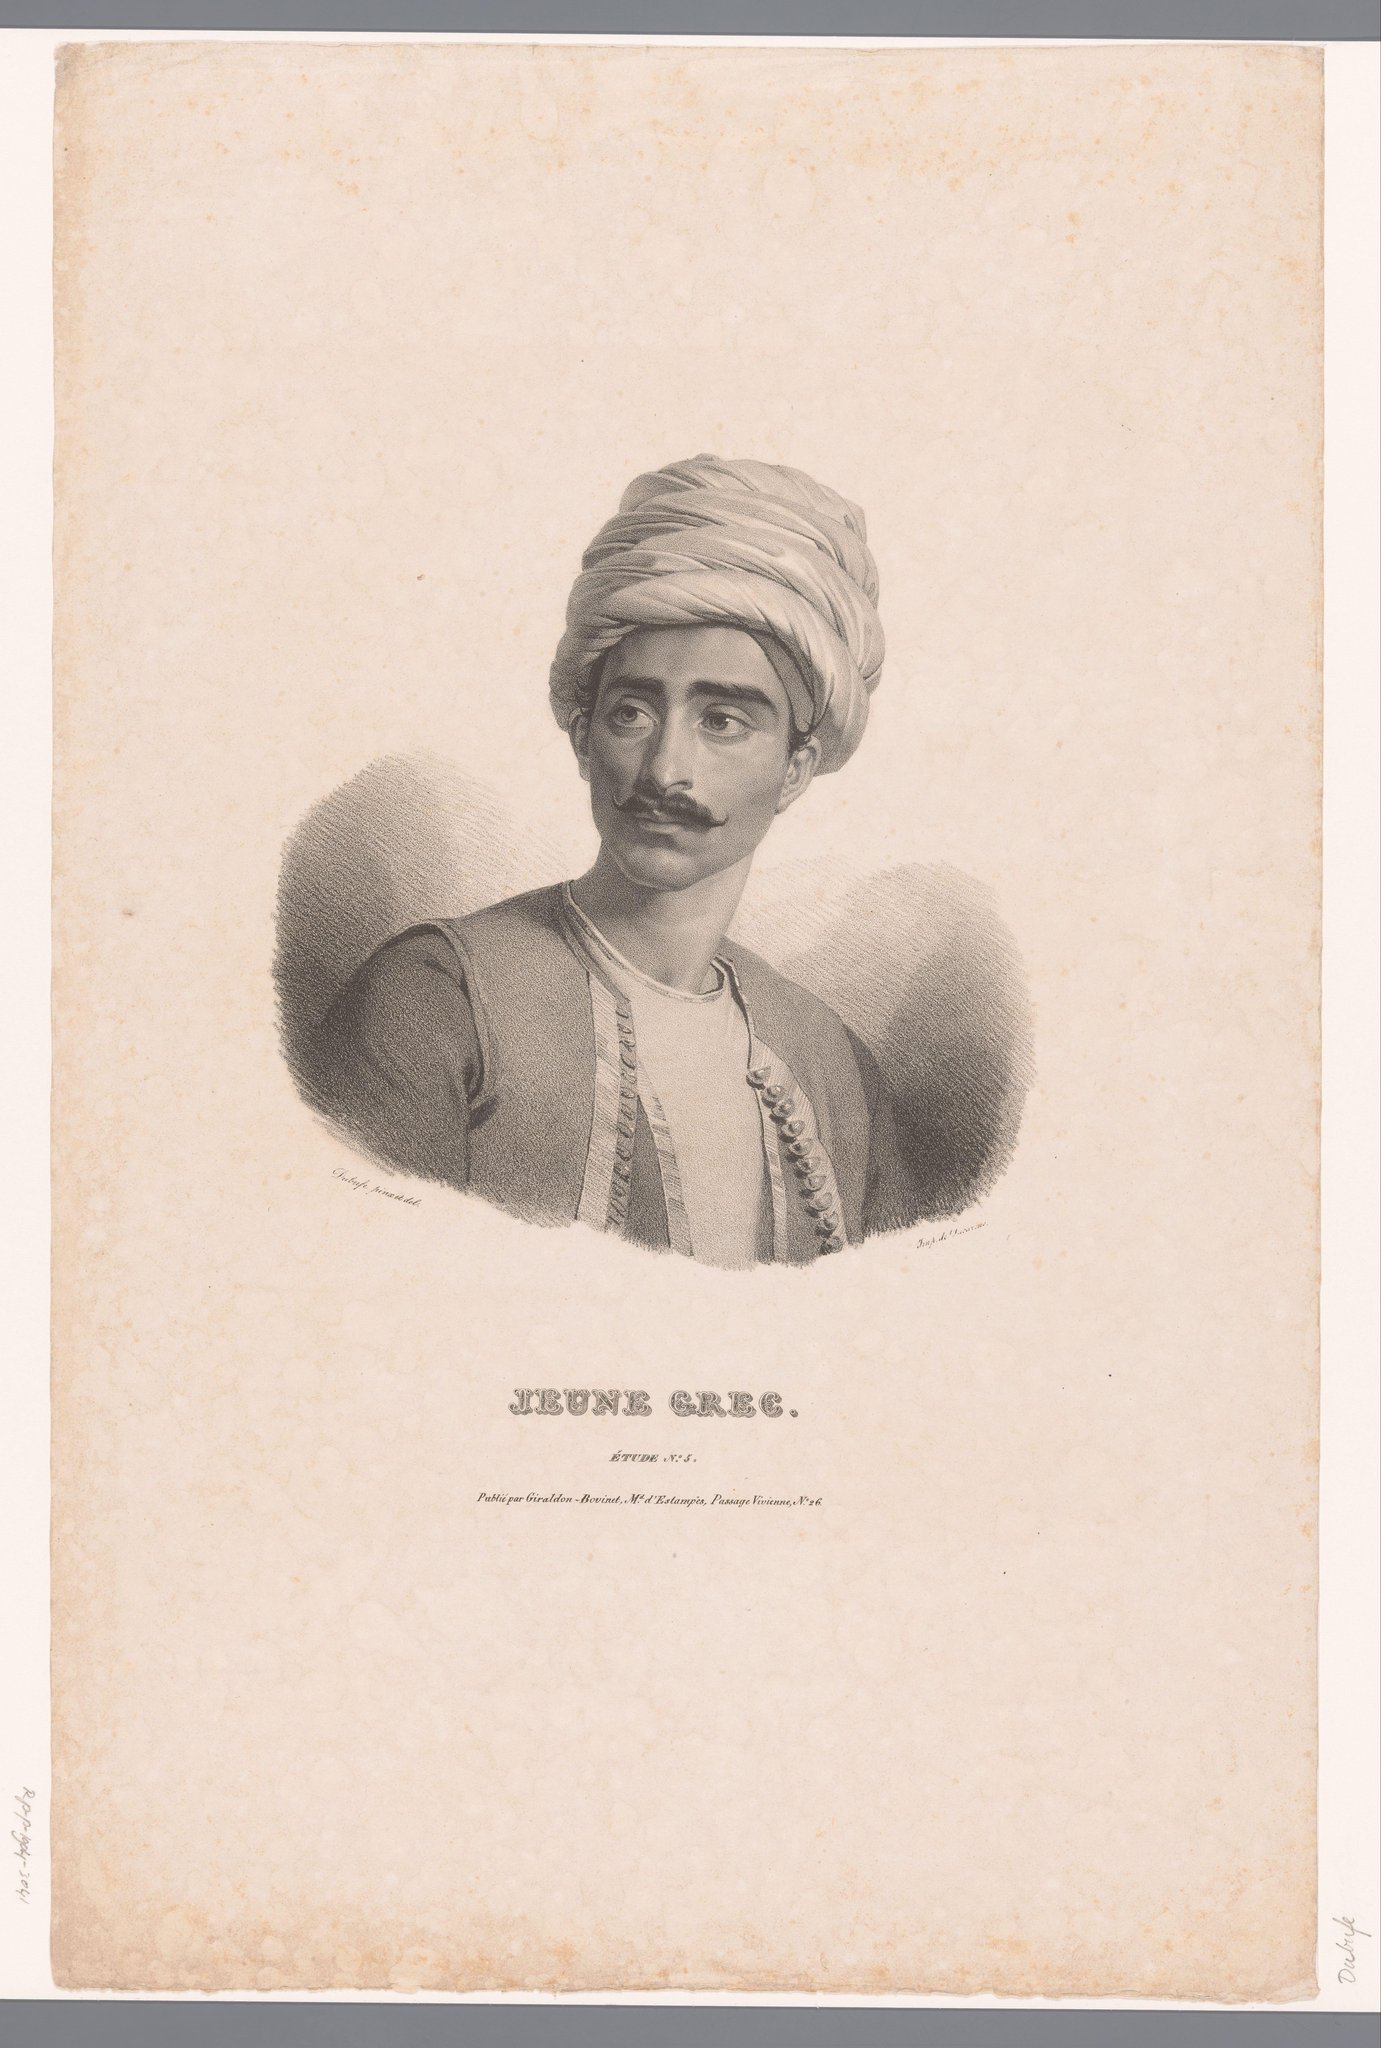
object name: print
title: Portret van een Griekse jongeman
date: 1820-1829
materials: paper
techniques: lithograph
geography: paris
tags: anonymous historical person portrayed alone, human races; peoples; nationalities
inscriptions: collector's mark: Lugt 2228a